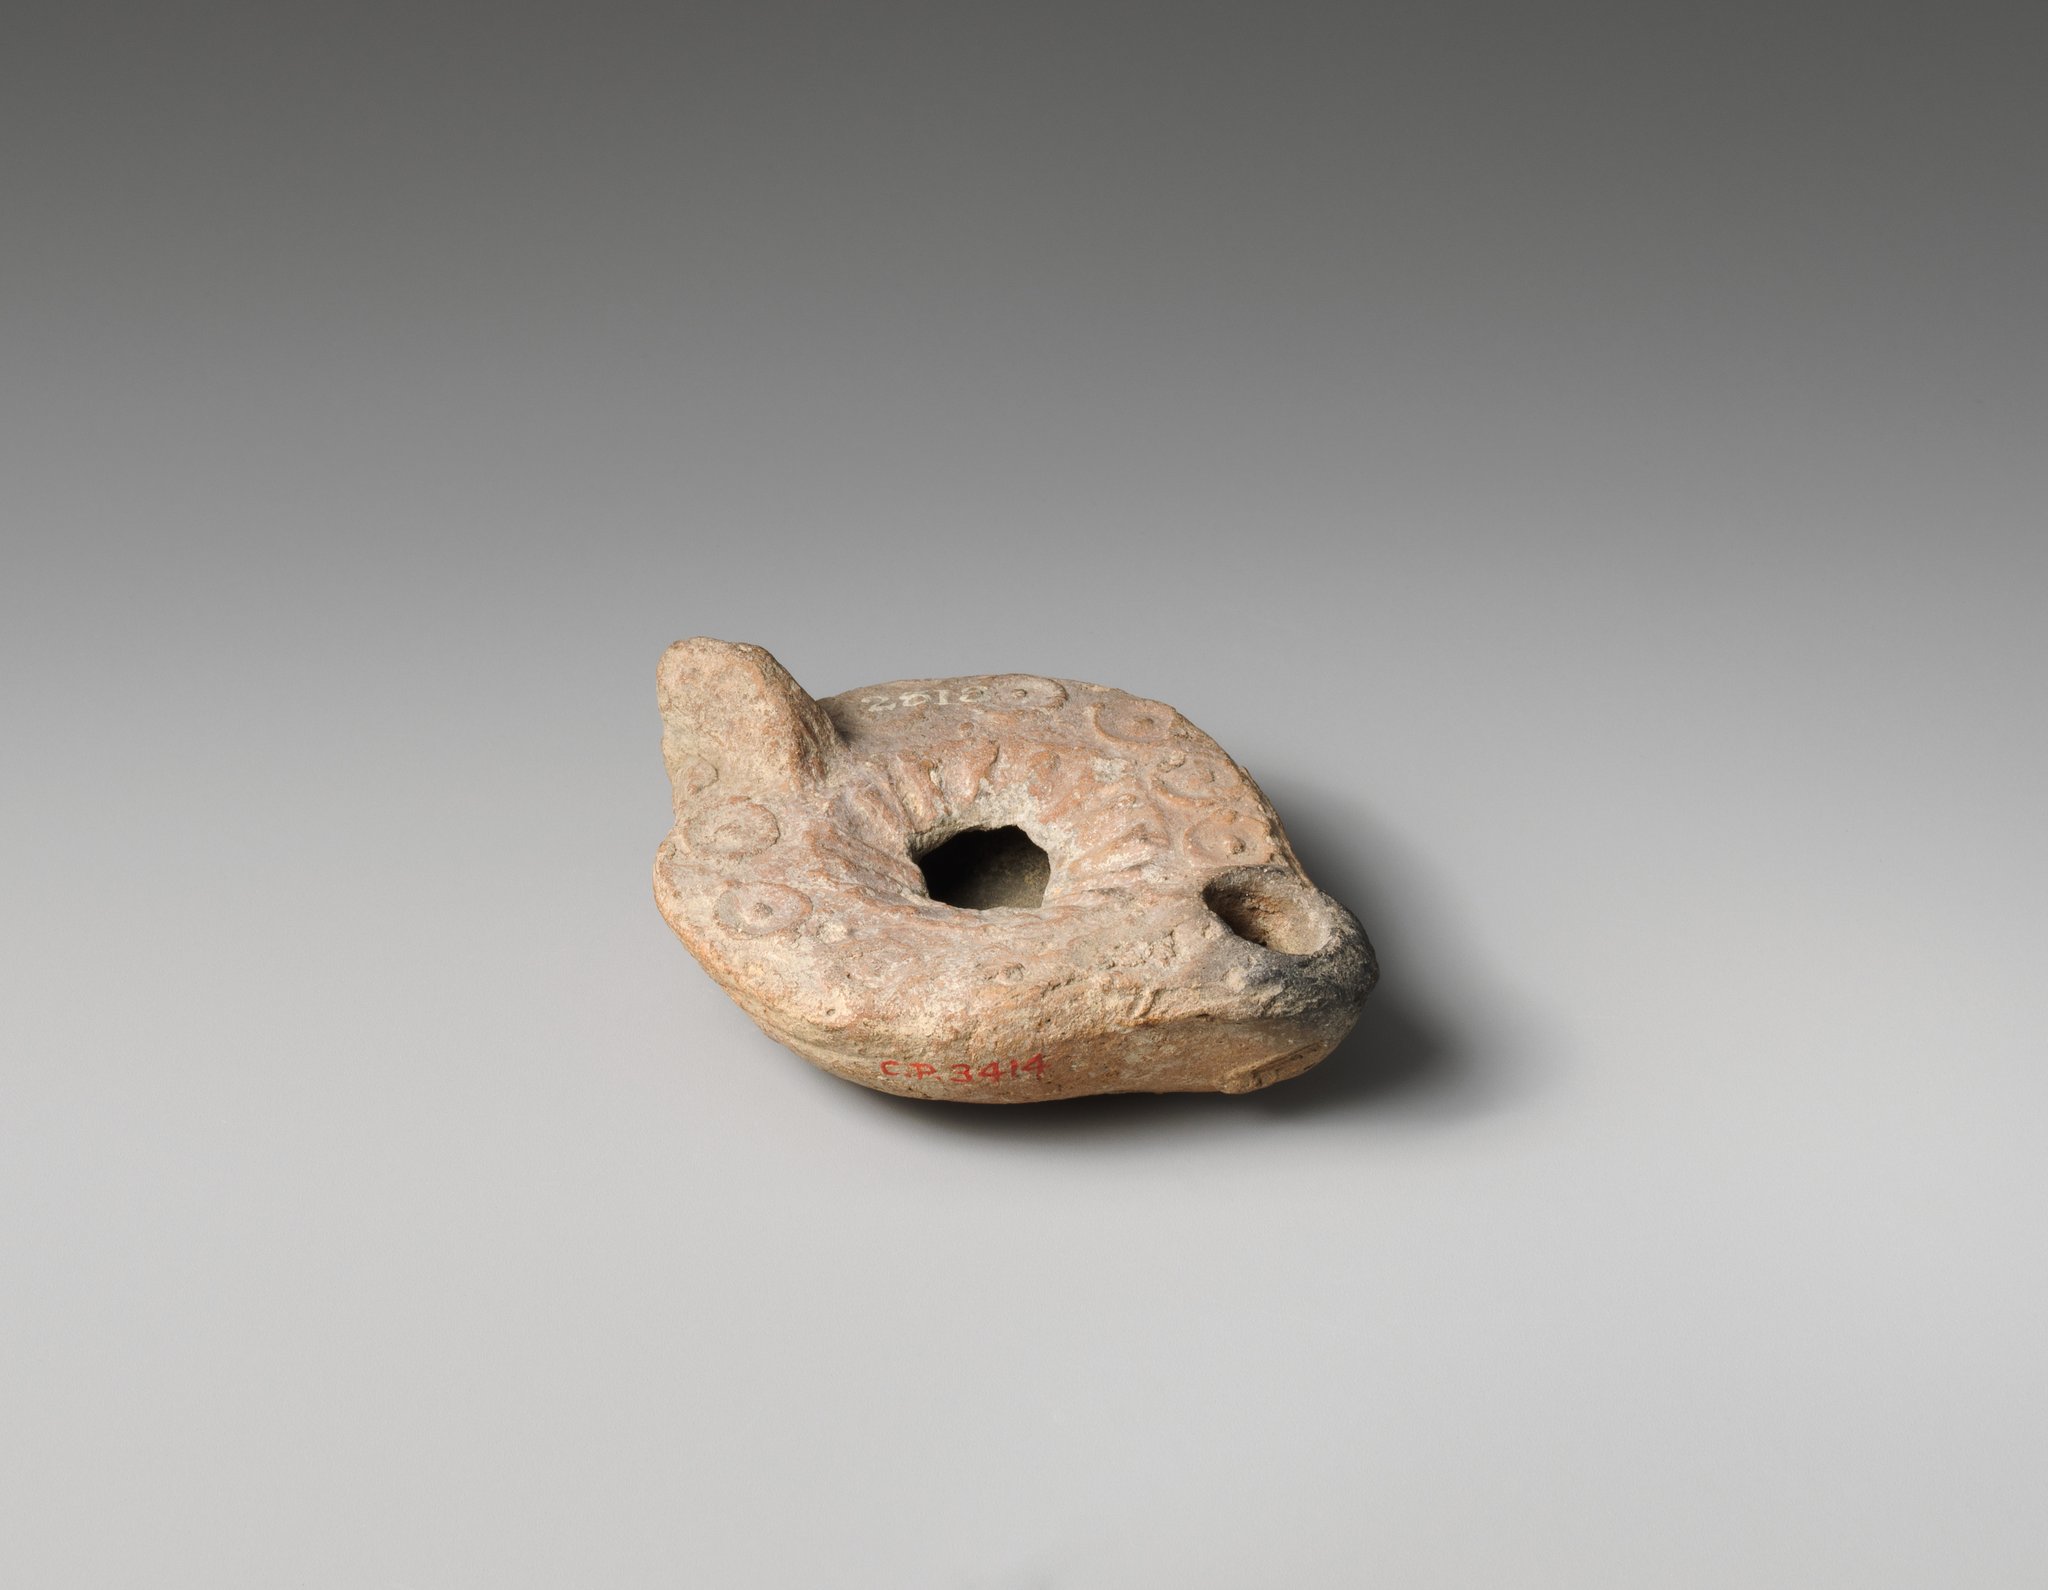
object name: lamp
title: Terracotta oil lamp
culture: roman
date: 301-400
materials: terracotta